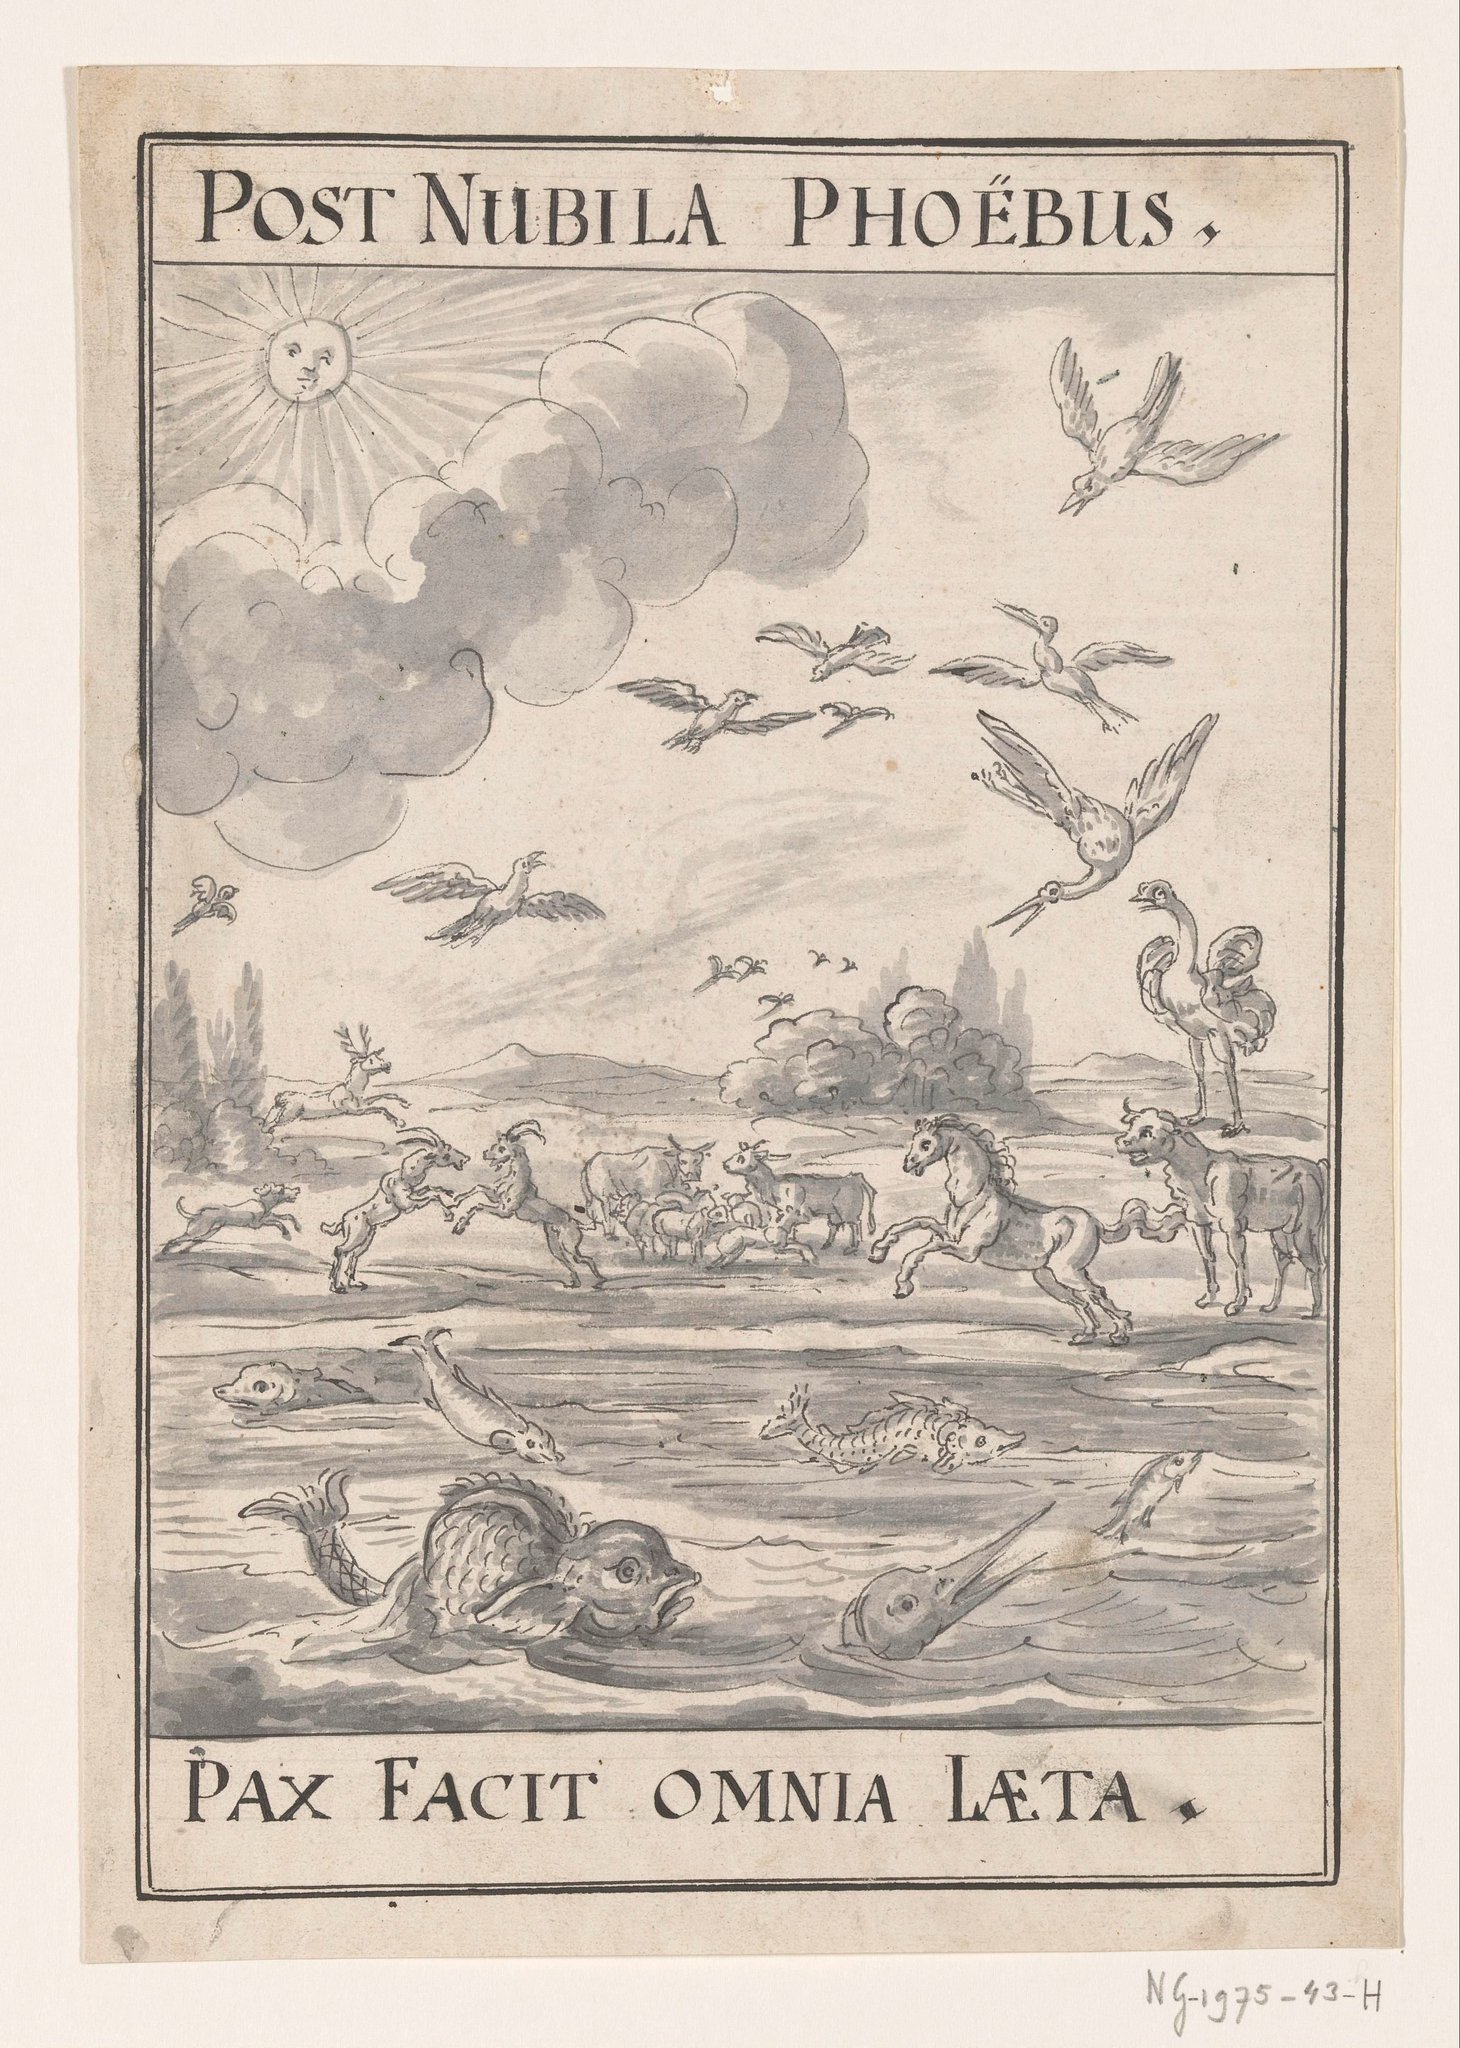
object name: drawing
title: Allegorisch embleem bij de Vrede van Rijswijk, 1697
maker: Anonymous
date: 1697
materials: ink, paper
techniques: brush, pen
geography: northern netherlands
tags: animals, clouds, sun represented as face, wheel, etc., festivities on events of national importance (+ festive decoration ~ festive activities)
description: Embleem met de zon die de wolken verdrijft, boven een landschap met dieren te land, te water en in de lucht. Opschrift: 'Post Nubila Phoëbus / Pax Facit omnia Laeta'. Ontwerp voor een decoratie bij de viering van de Vrede van Rijswijk in 1697.